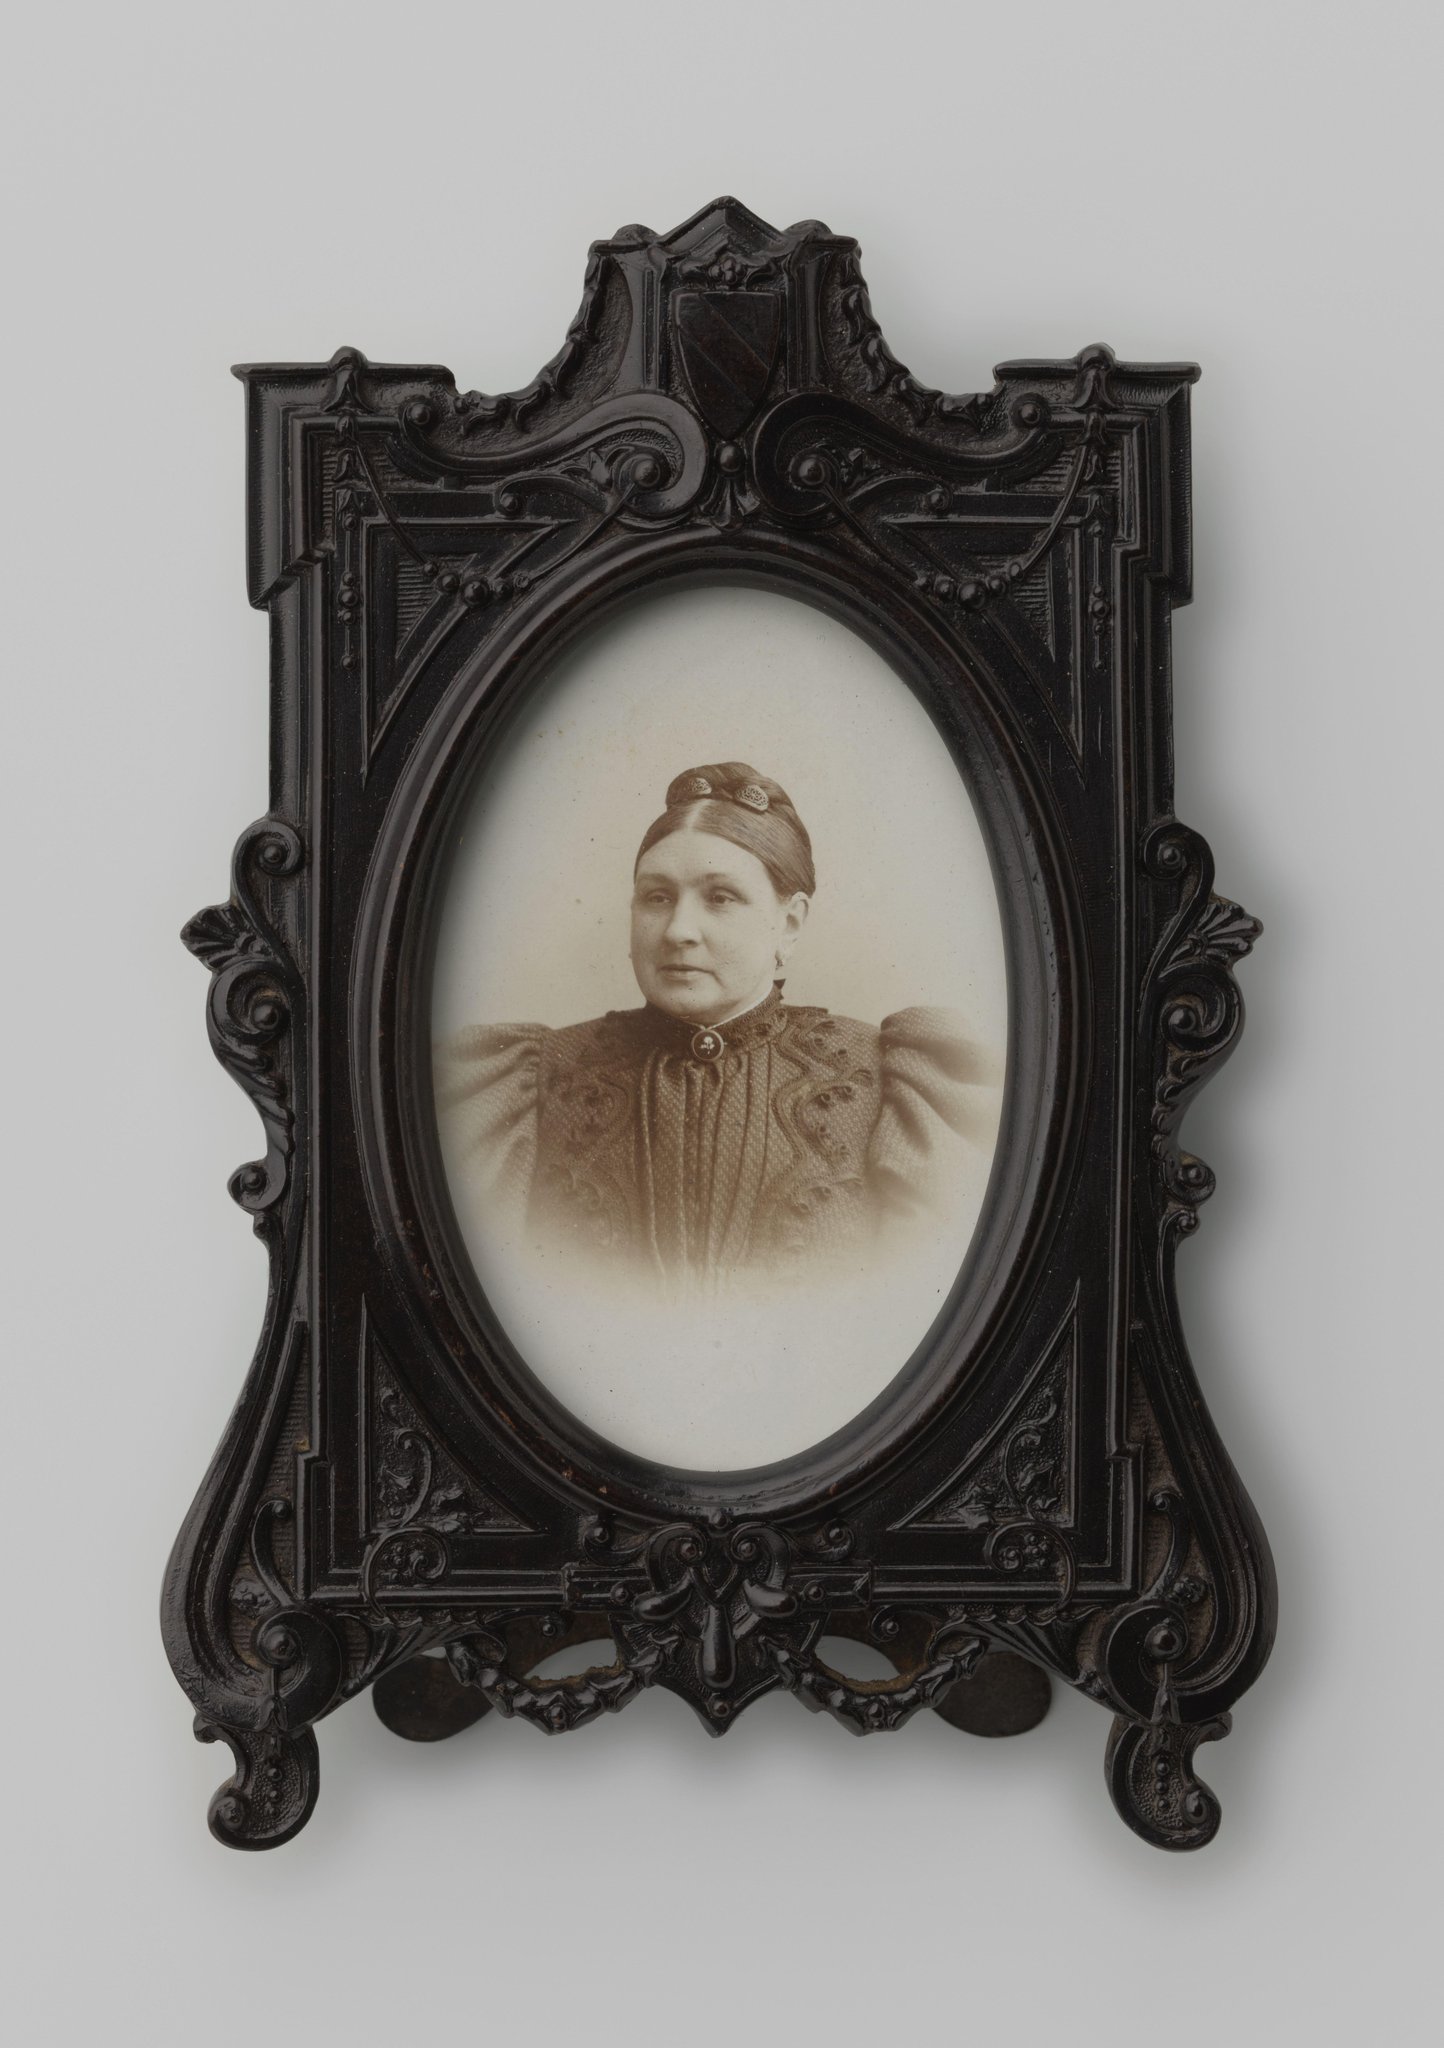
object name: photograph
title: Portret van een onbekende vrouw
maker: albert greiner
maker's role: fotograaf, fotostudio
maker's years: 1833-1890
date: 1861-1890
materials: paper, glass, metal, wood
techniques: collodion silver print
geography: amsterdam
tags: adult woman, anonymous historical person portrayed